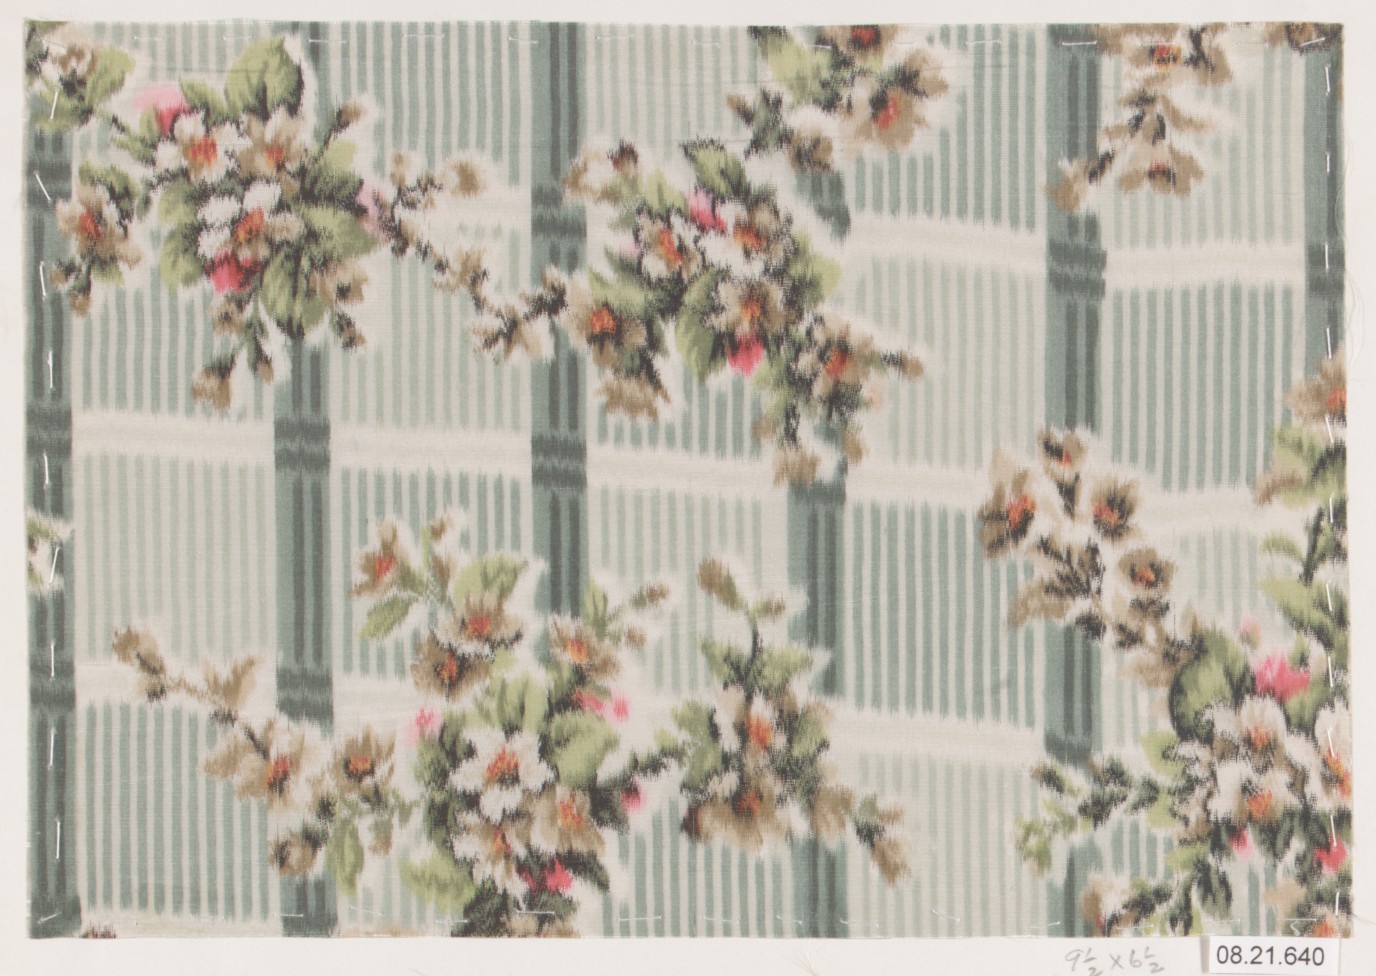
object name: textile sample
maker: Anonymous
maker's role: designer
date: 1900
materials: silk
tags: flowers